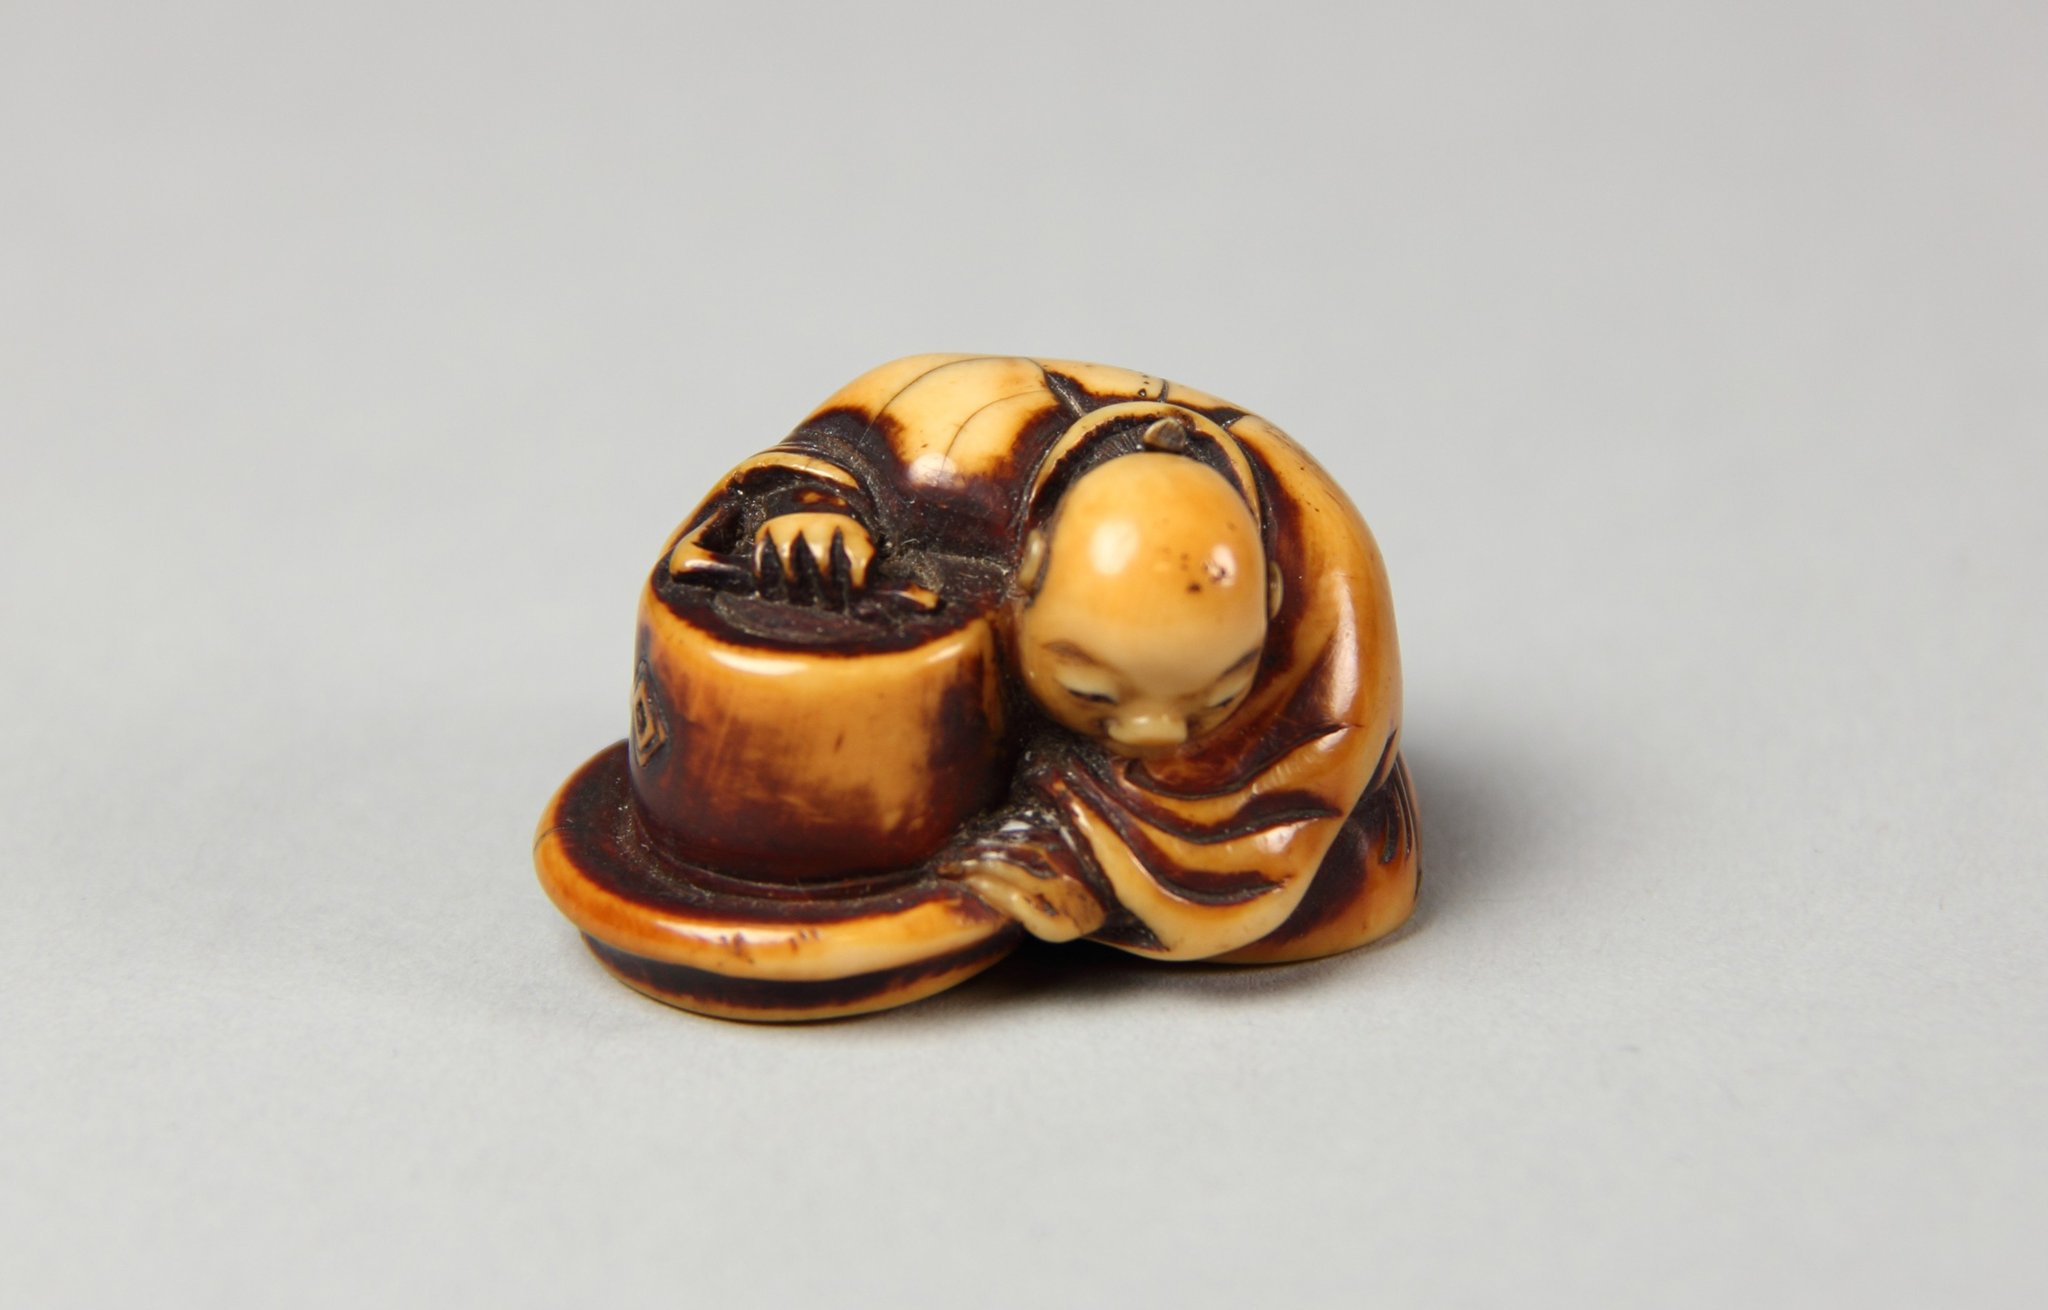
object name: netsuke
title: Netsuke of Merchant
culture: japanese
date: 1834-1866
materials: ivory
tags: men,merchants